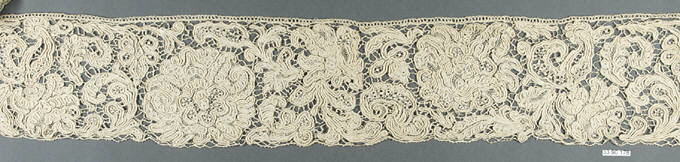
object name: edging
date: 1701-1800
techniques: lace